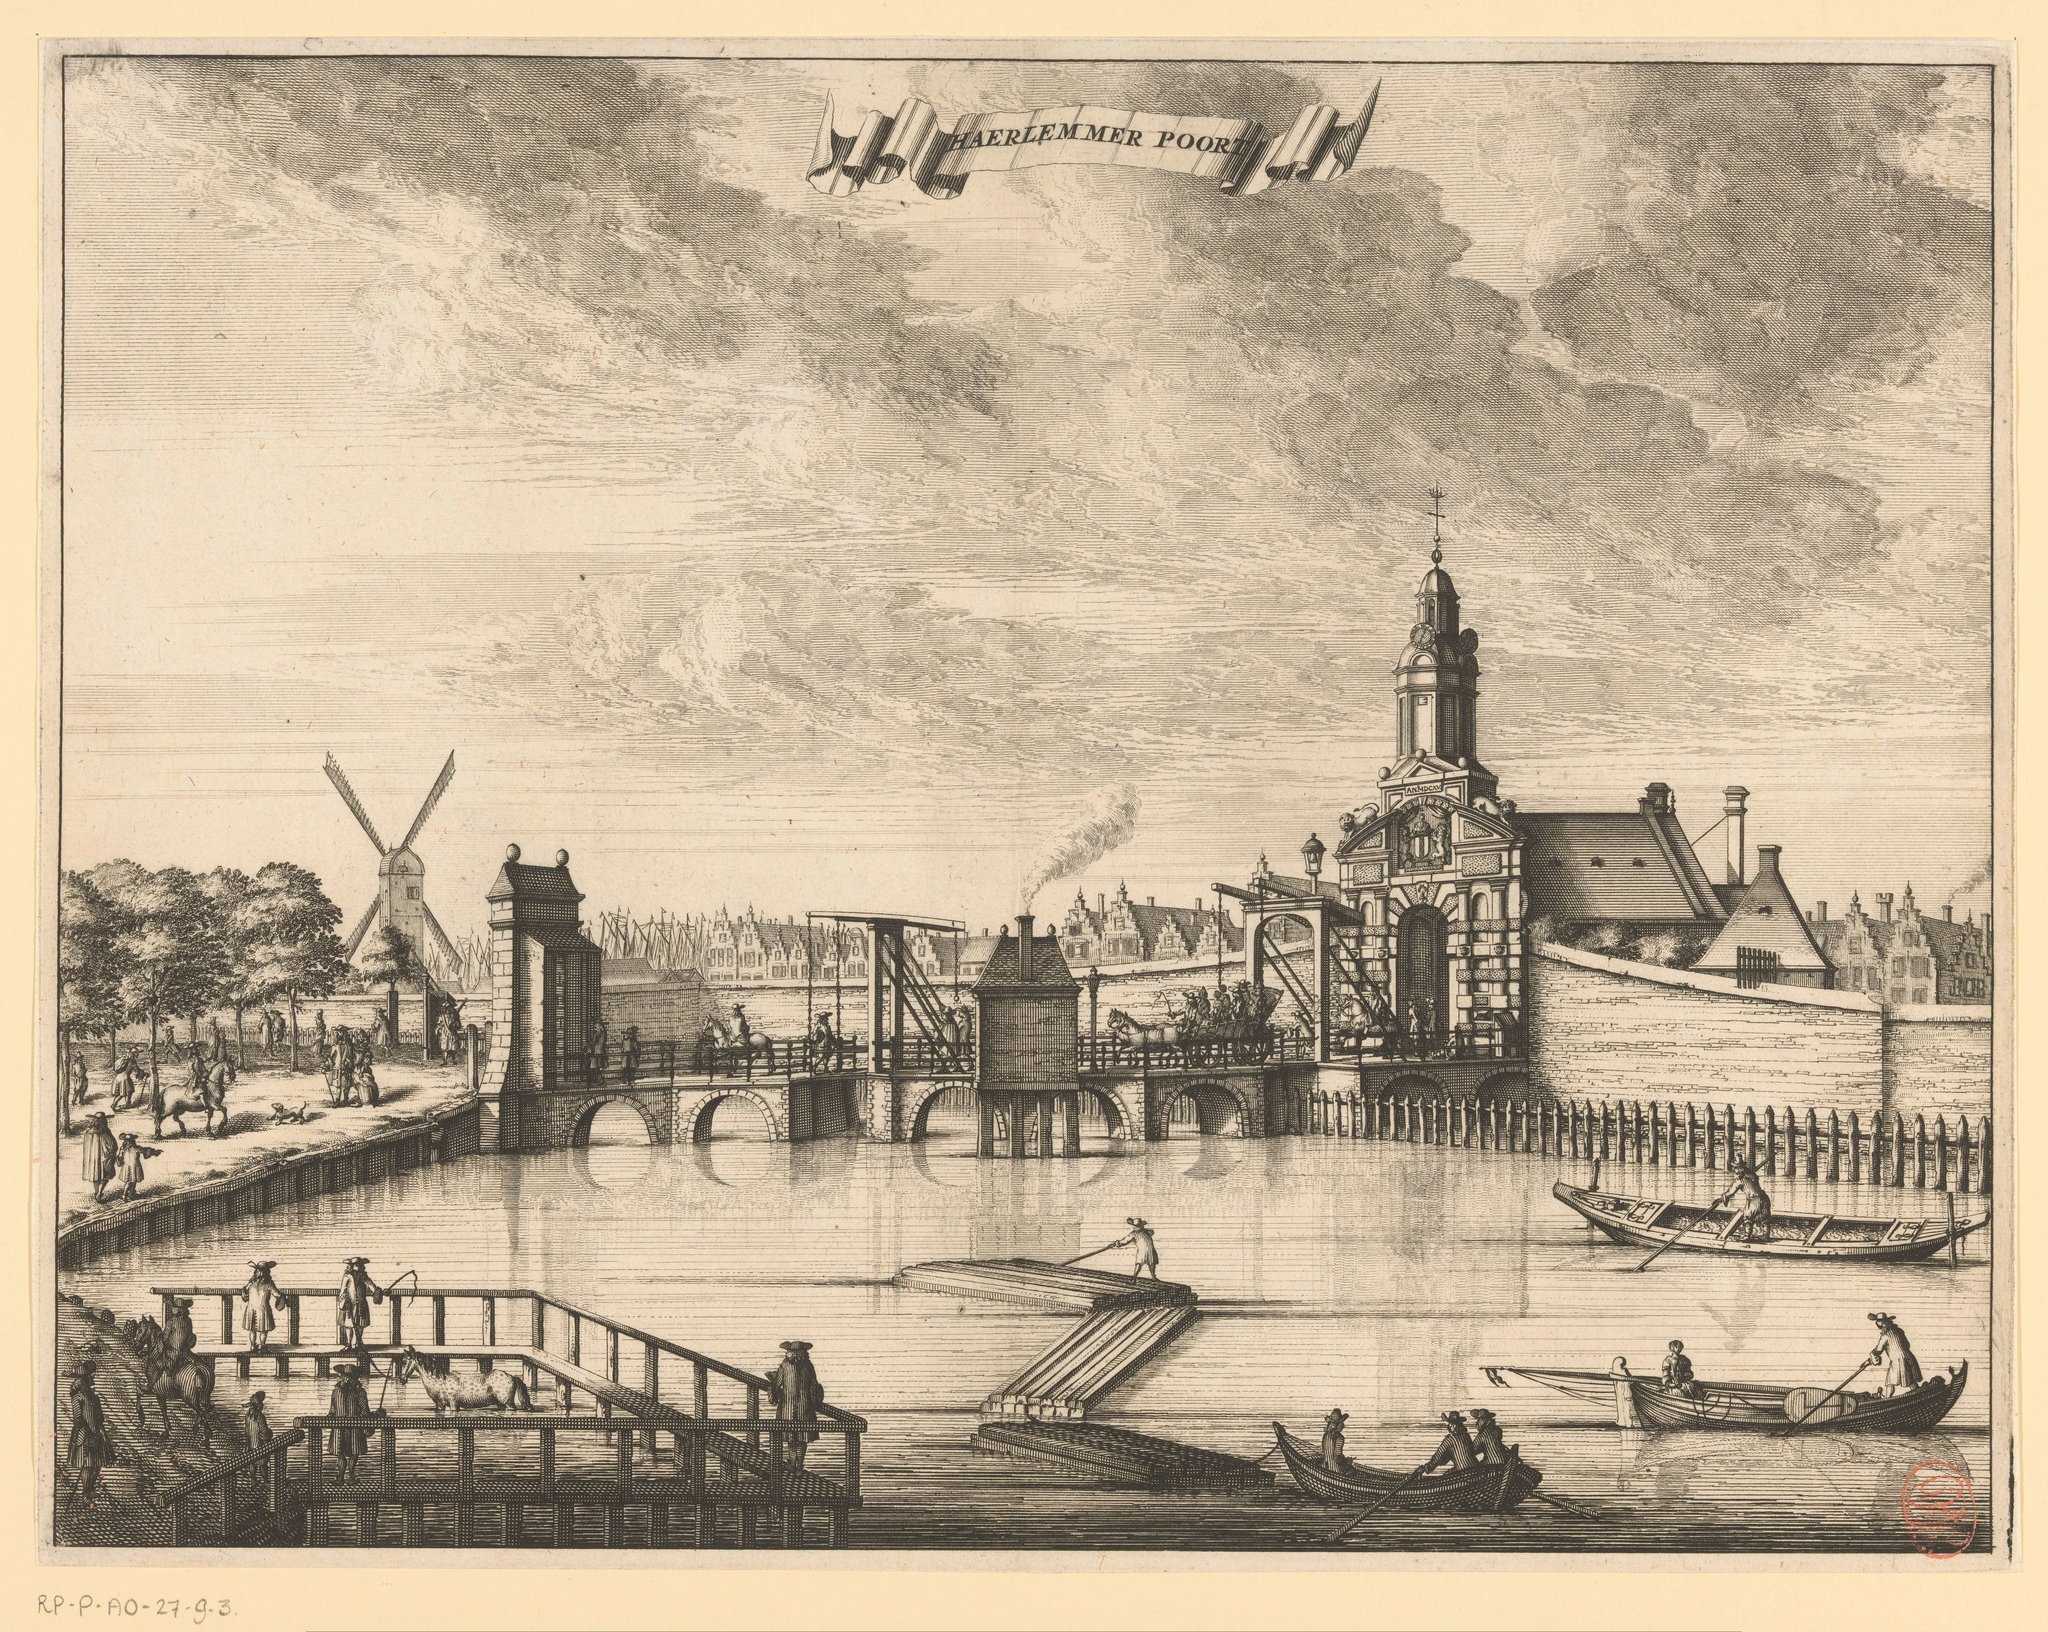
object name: print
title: Gezicht op de Haarlemmerpoort te Amsterdam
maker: Anonymous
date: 1693-1694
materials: paper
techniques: engraving, etching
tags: bridge, city-gate, canal (+ landscape with figures, staffage)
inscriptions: collector's mark: Lugt 195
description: Huidige staat van prent ook gebruikt in: Commelin, Caspar. Beschryvinge van Amsterdam, desselfs eerste oorspronk uyt den Huyse (…). 2 delen. Amsterdam: Abraham Wolfgang, Gillis Janssonius van Waesberge, Johannes Janssonius van Waesberge II, weduwe Dirk Boom I, Hendrick Boom en Rembertus Goethals, 1693. En in: Commelin, Caspar. Beschryvinge van Amsterdam, zynde een naukeurige verhandelinge van desselfs eerste oorspronk uyt (…). 2 delen. Amsterdam: weduwe Aart Dircksz Oossaan, 1694. Latere staat ook gebruikt in: Commelin, Caspar. Beschryvinge van Amsterdam, zynde een naukeurige verhandelinge van desselfs eerste oorspronk uyt (…). 2 delen. 2e druk. Amsterdam: Andries van Damme, Johannes Ratelband, weduwe A. van Aaltwyk en Hermanus Uytwerf, 1726.